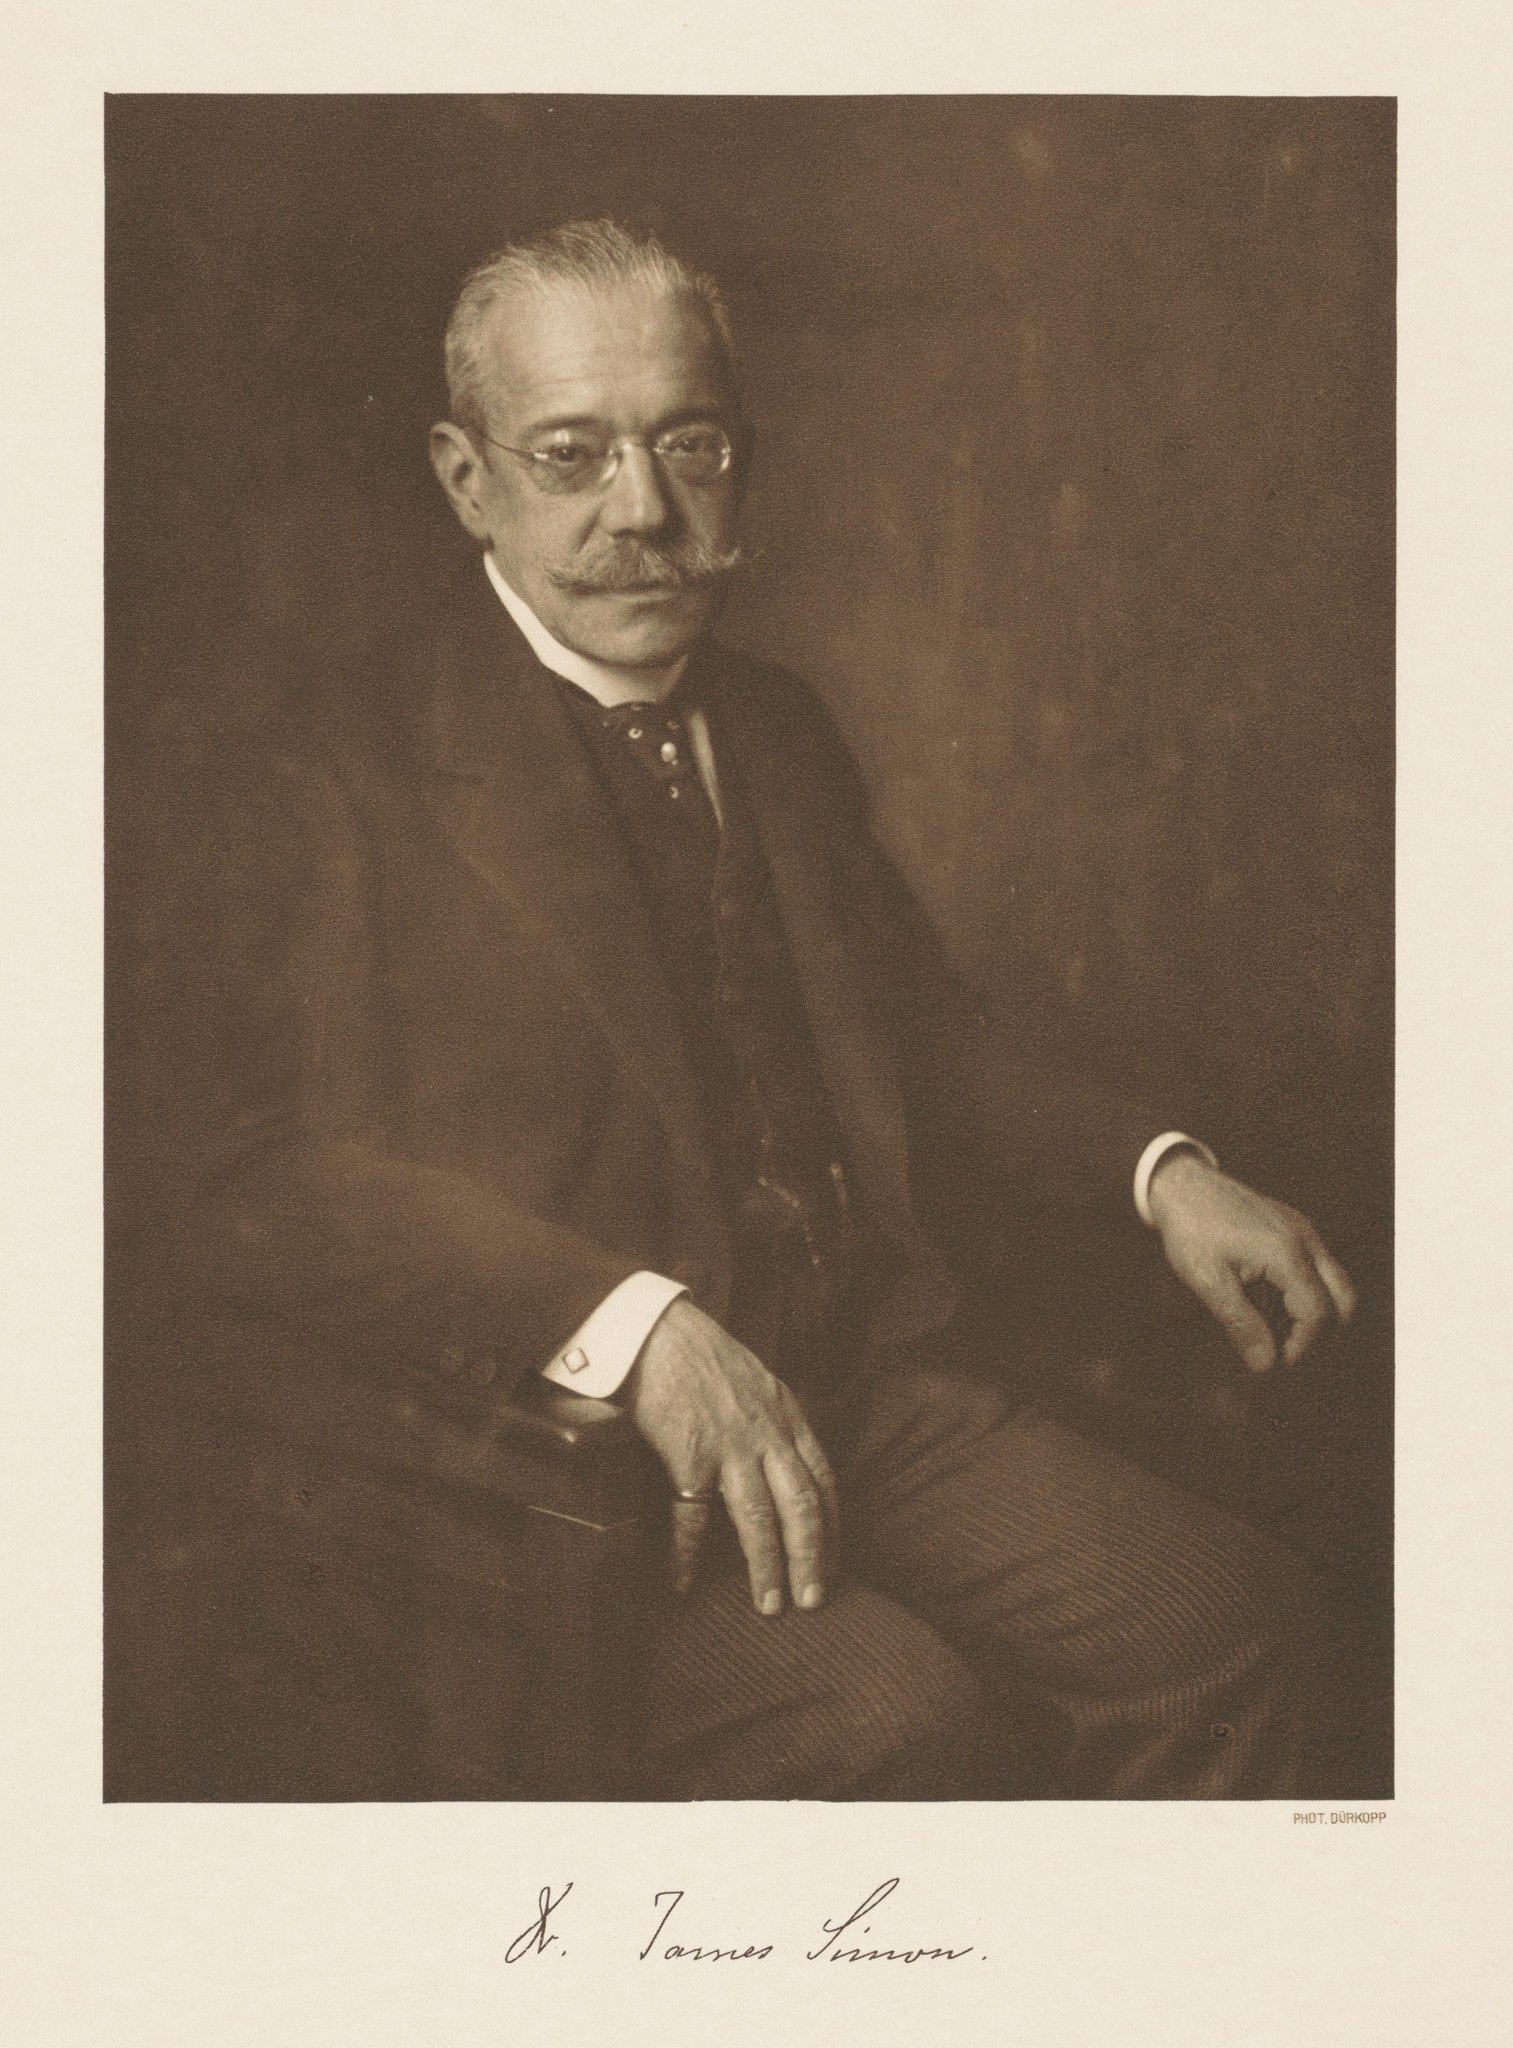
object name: photomechanical print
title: Portret van Dr. James Simon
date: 1895-1910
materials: cardboard, paper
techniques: photoaquatint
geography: berlin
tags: berlin, adult man, historical persons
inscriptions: inscription: ‘PHOT. DÜRKOPP’, signature: ‘H. James Simon’